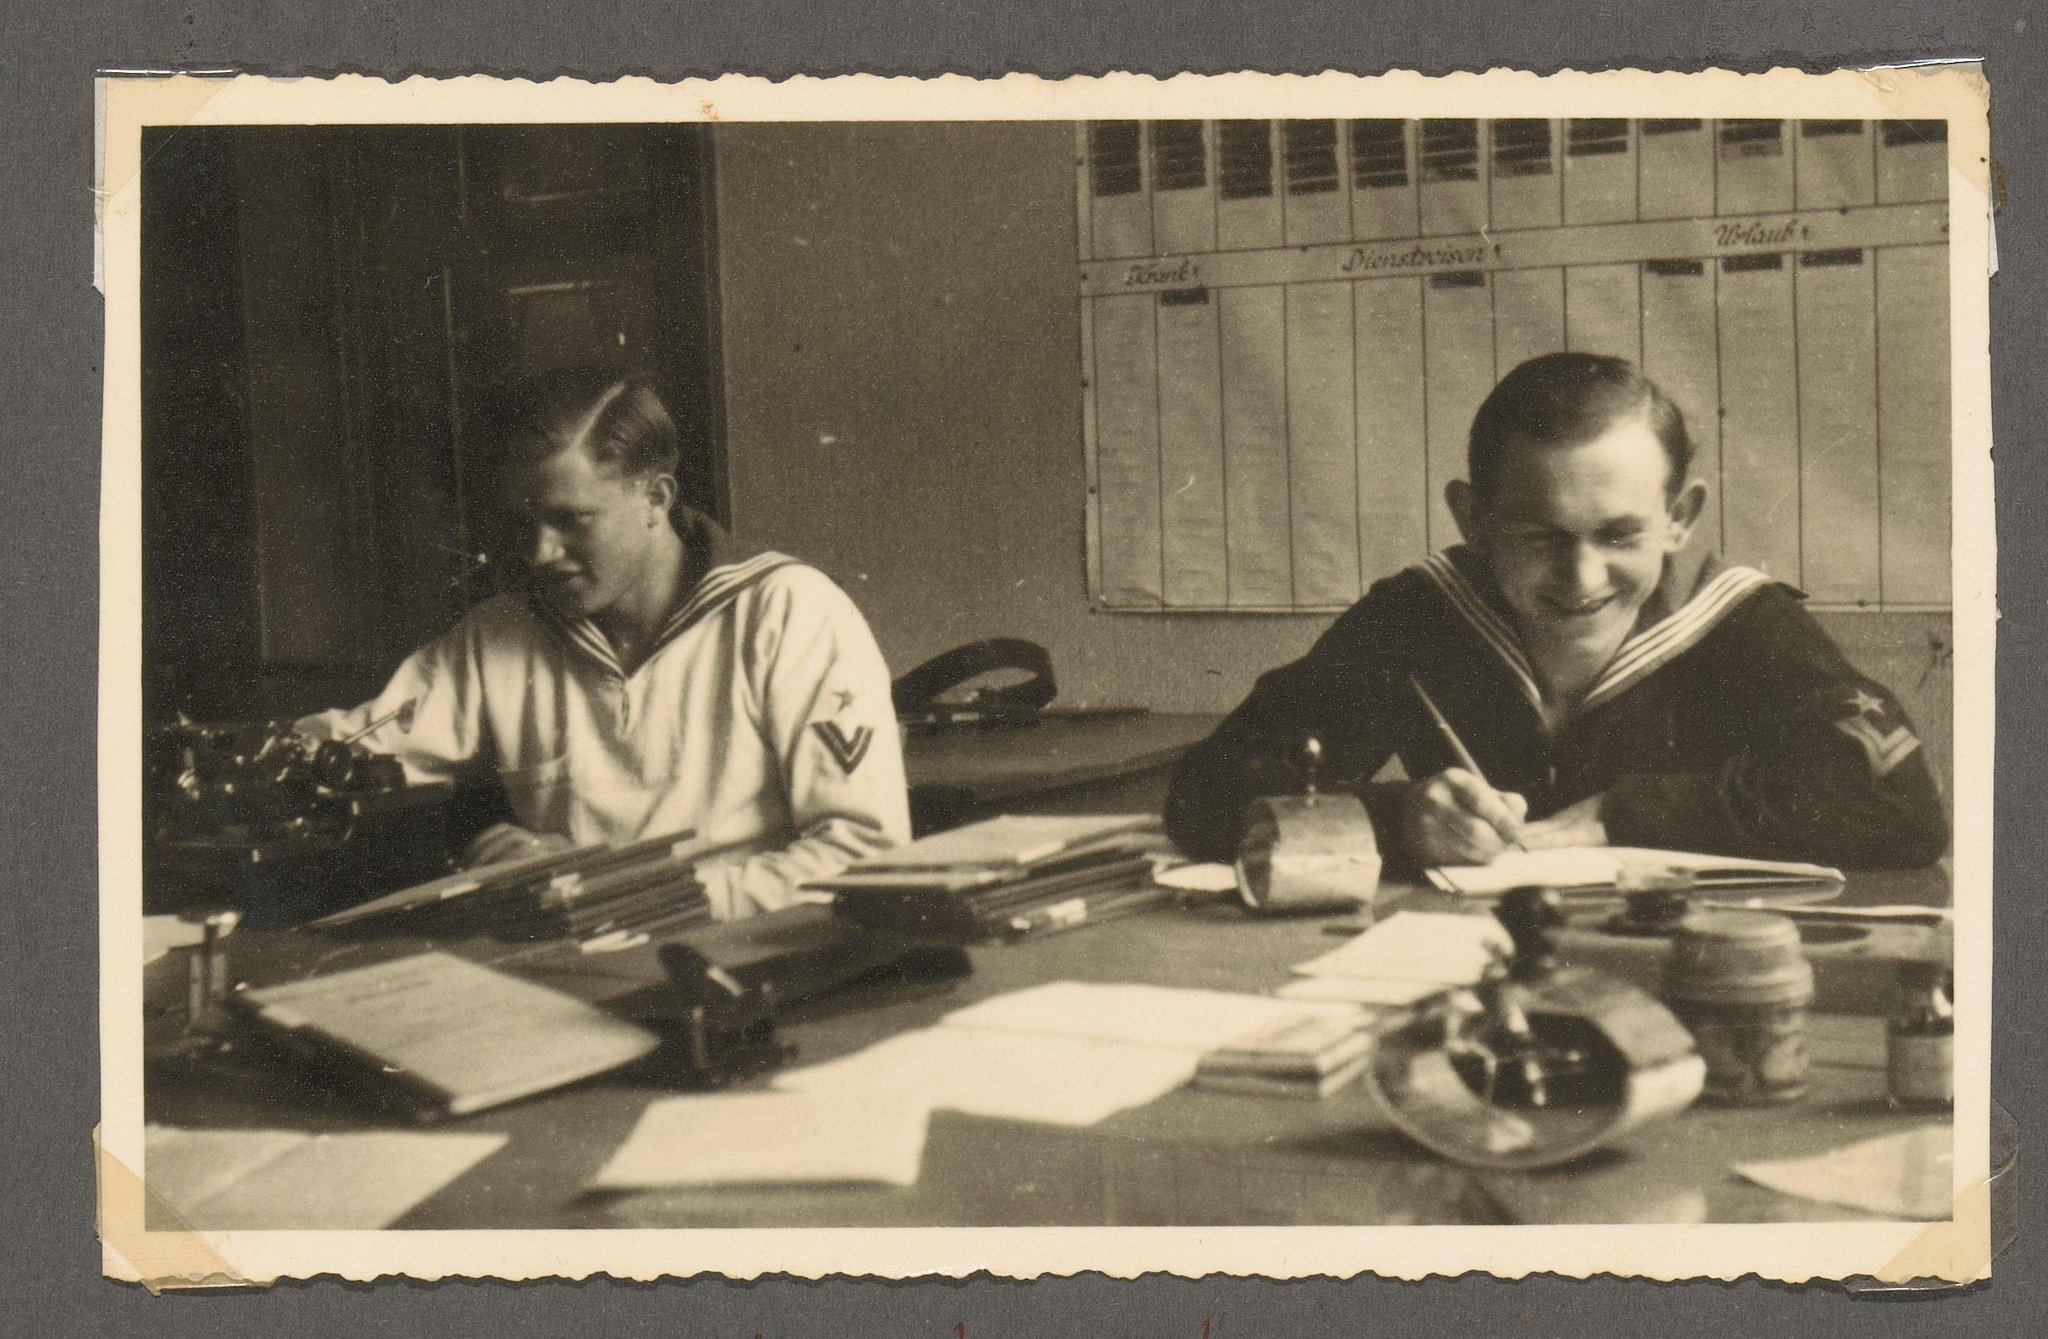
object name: photograph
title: Twee militairen aan een bureau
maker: Anonymous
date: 1941-1945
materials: paper, photographic support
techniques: gelatin silver print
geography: vlaardingen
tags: writing-table, writing-desk, the soldier; the soldier's life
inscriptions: annotation: ‘Die Wachtmeistergasten der/ A. R. Flott. auf der Dienststellein Vlaardingen’